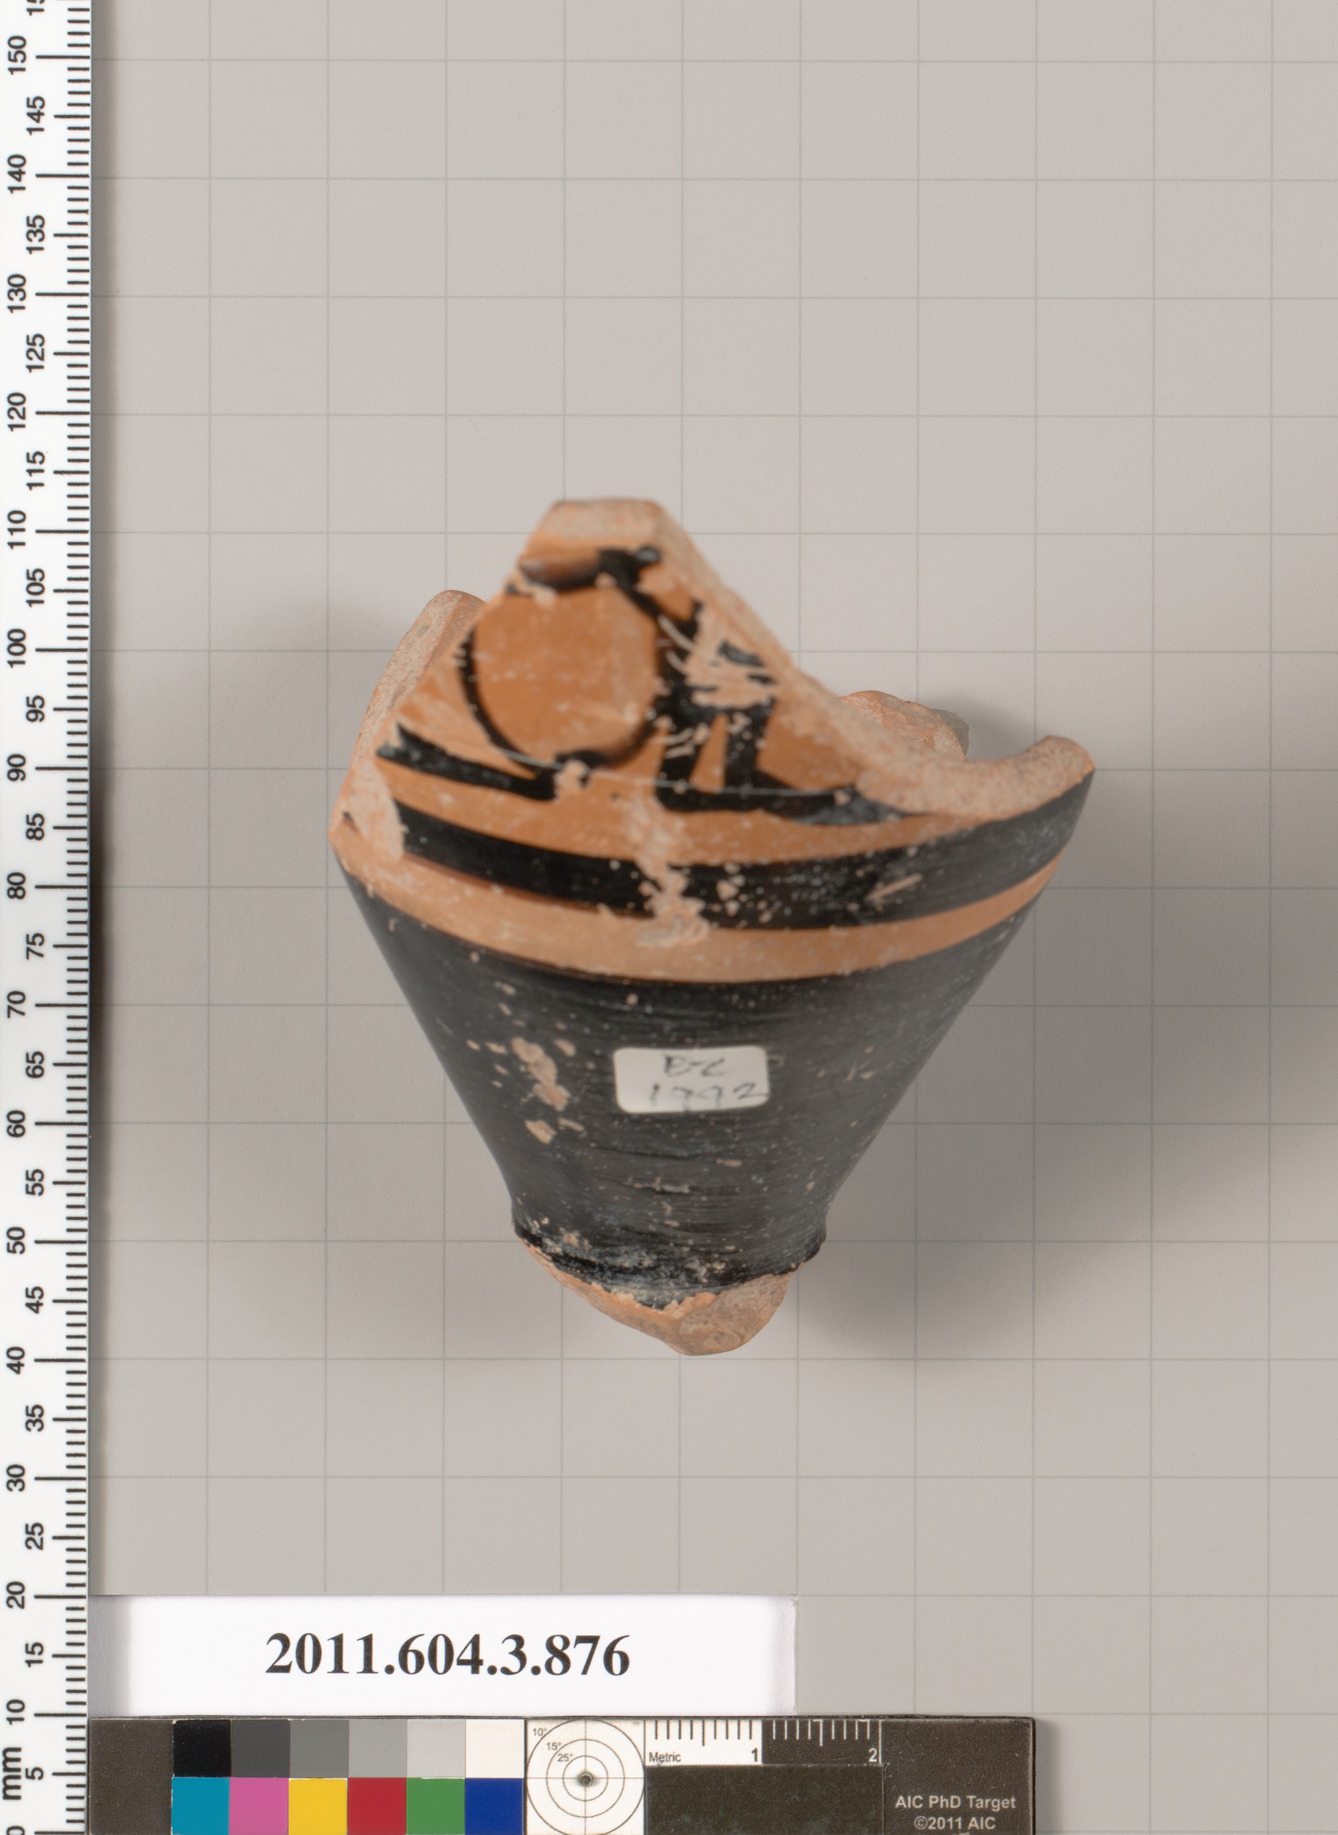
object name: lekythos fragment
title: Terracotta fragment of a lekythos (oil flask)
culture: greek, attic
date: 500-468 BCE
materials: terracotta